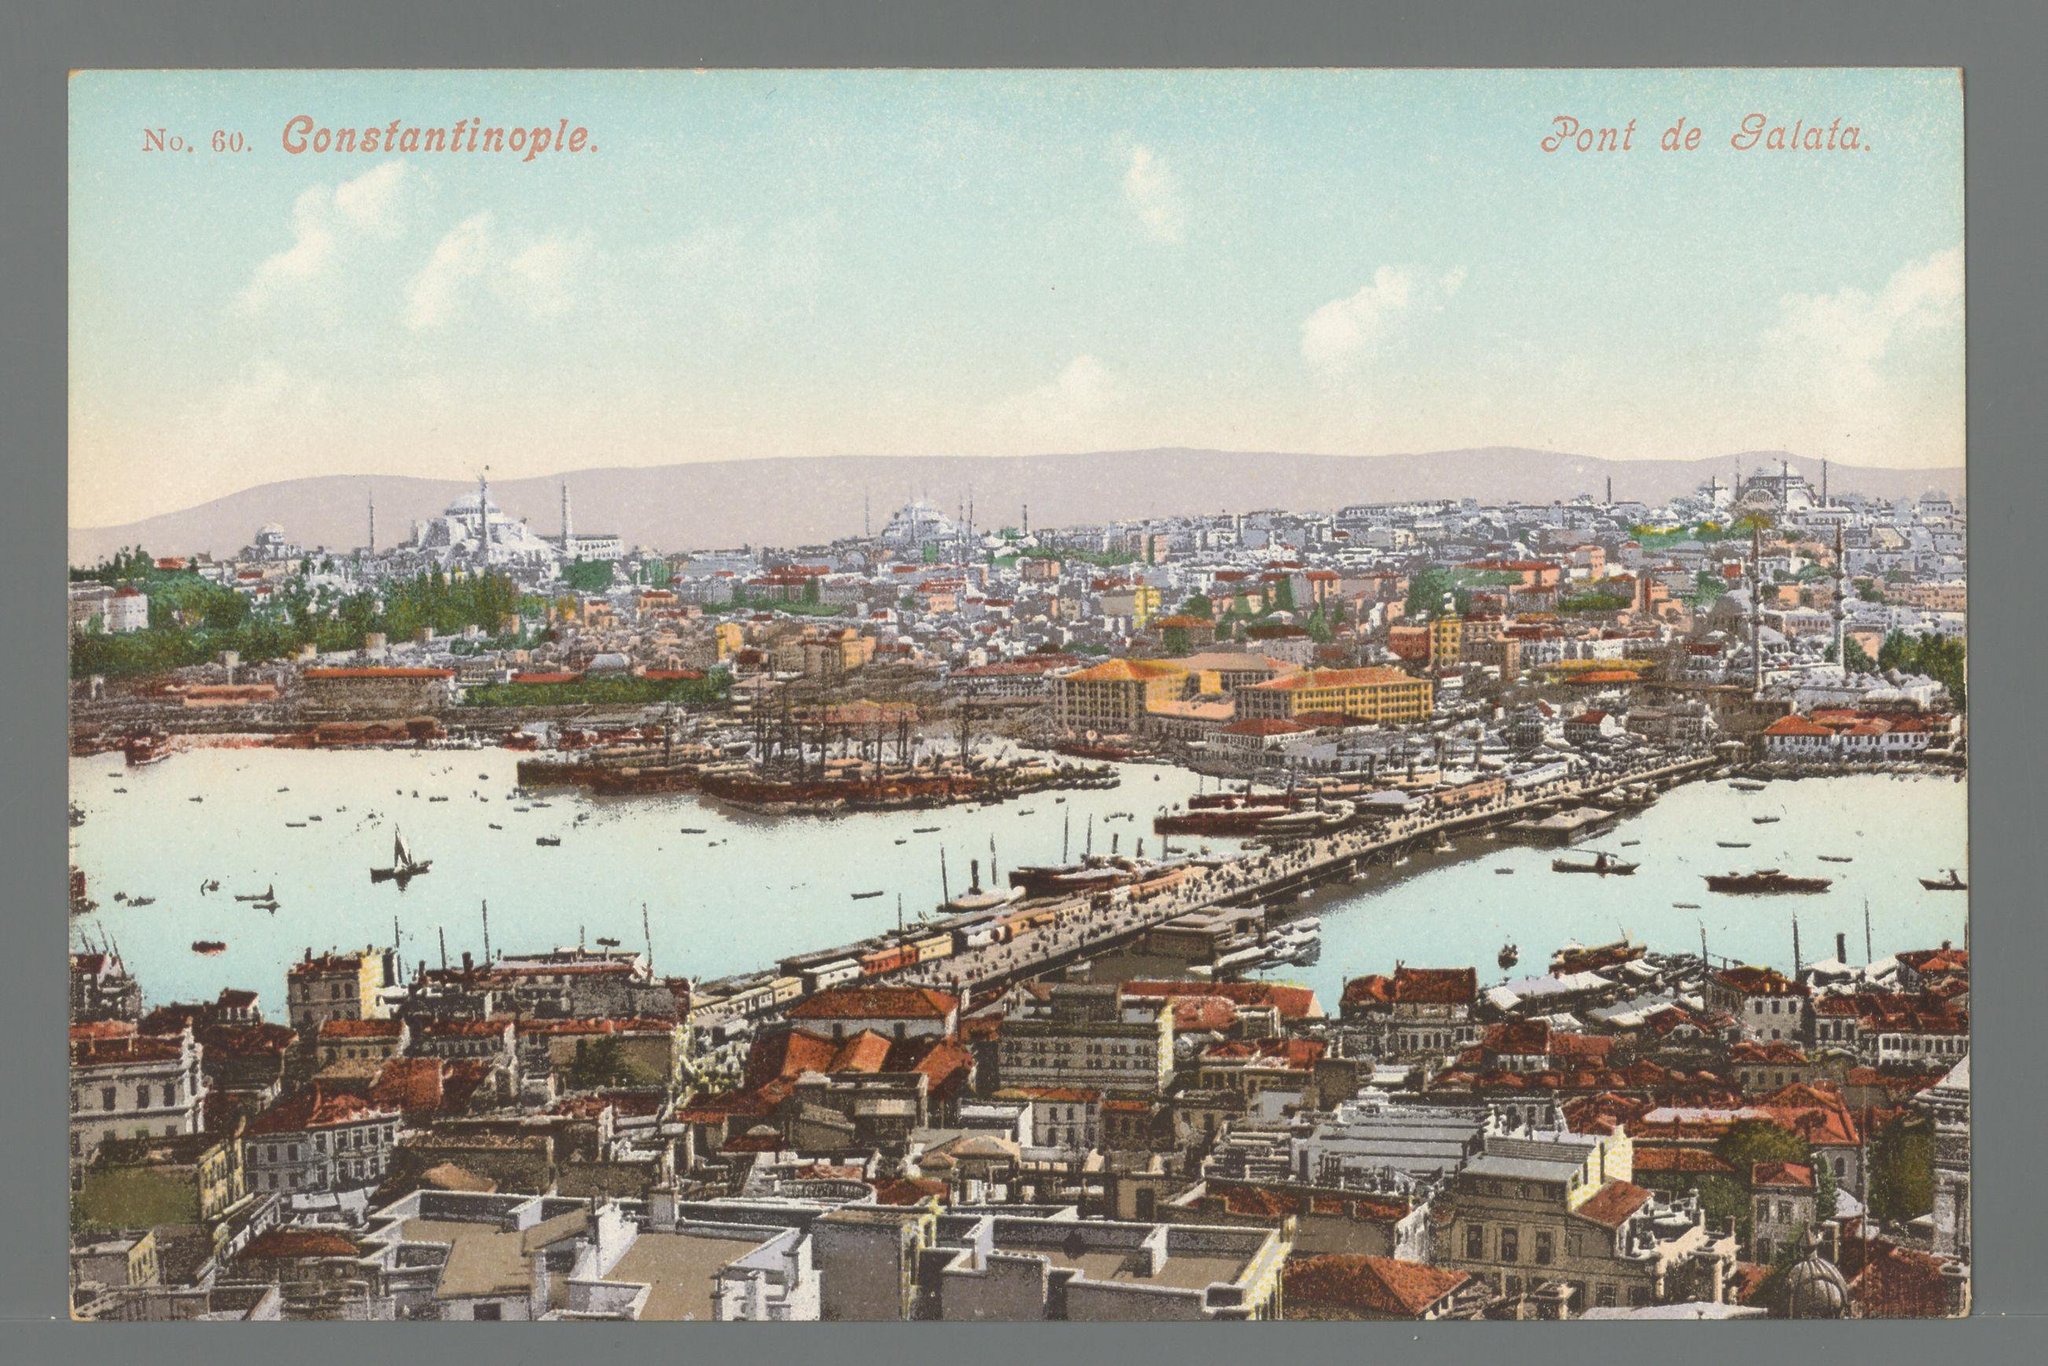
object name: ansichtkaart, prentbriefkaart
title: Constantinople. Pont de Galata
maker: Anonymous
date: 1906-1920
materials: cardboard, photographic process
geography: constantinople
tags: bridge in city across river, canal, etc. (+ city(-scape) with figures, staffage), prospect of city, town panorama, silhouette of city (+ city(-scape) with figures, staffage)